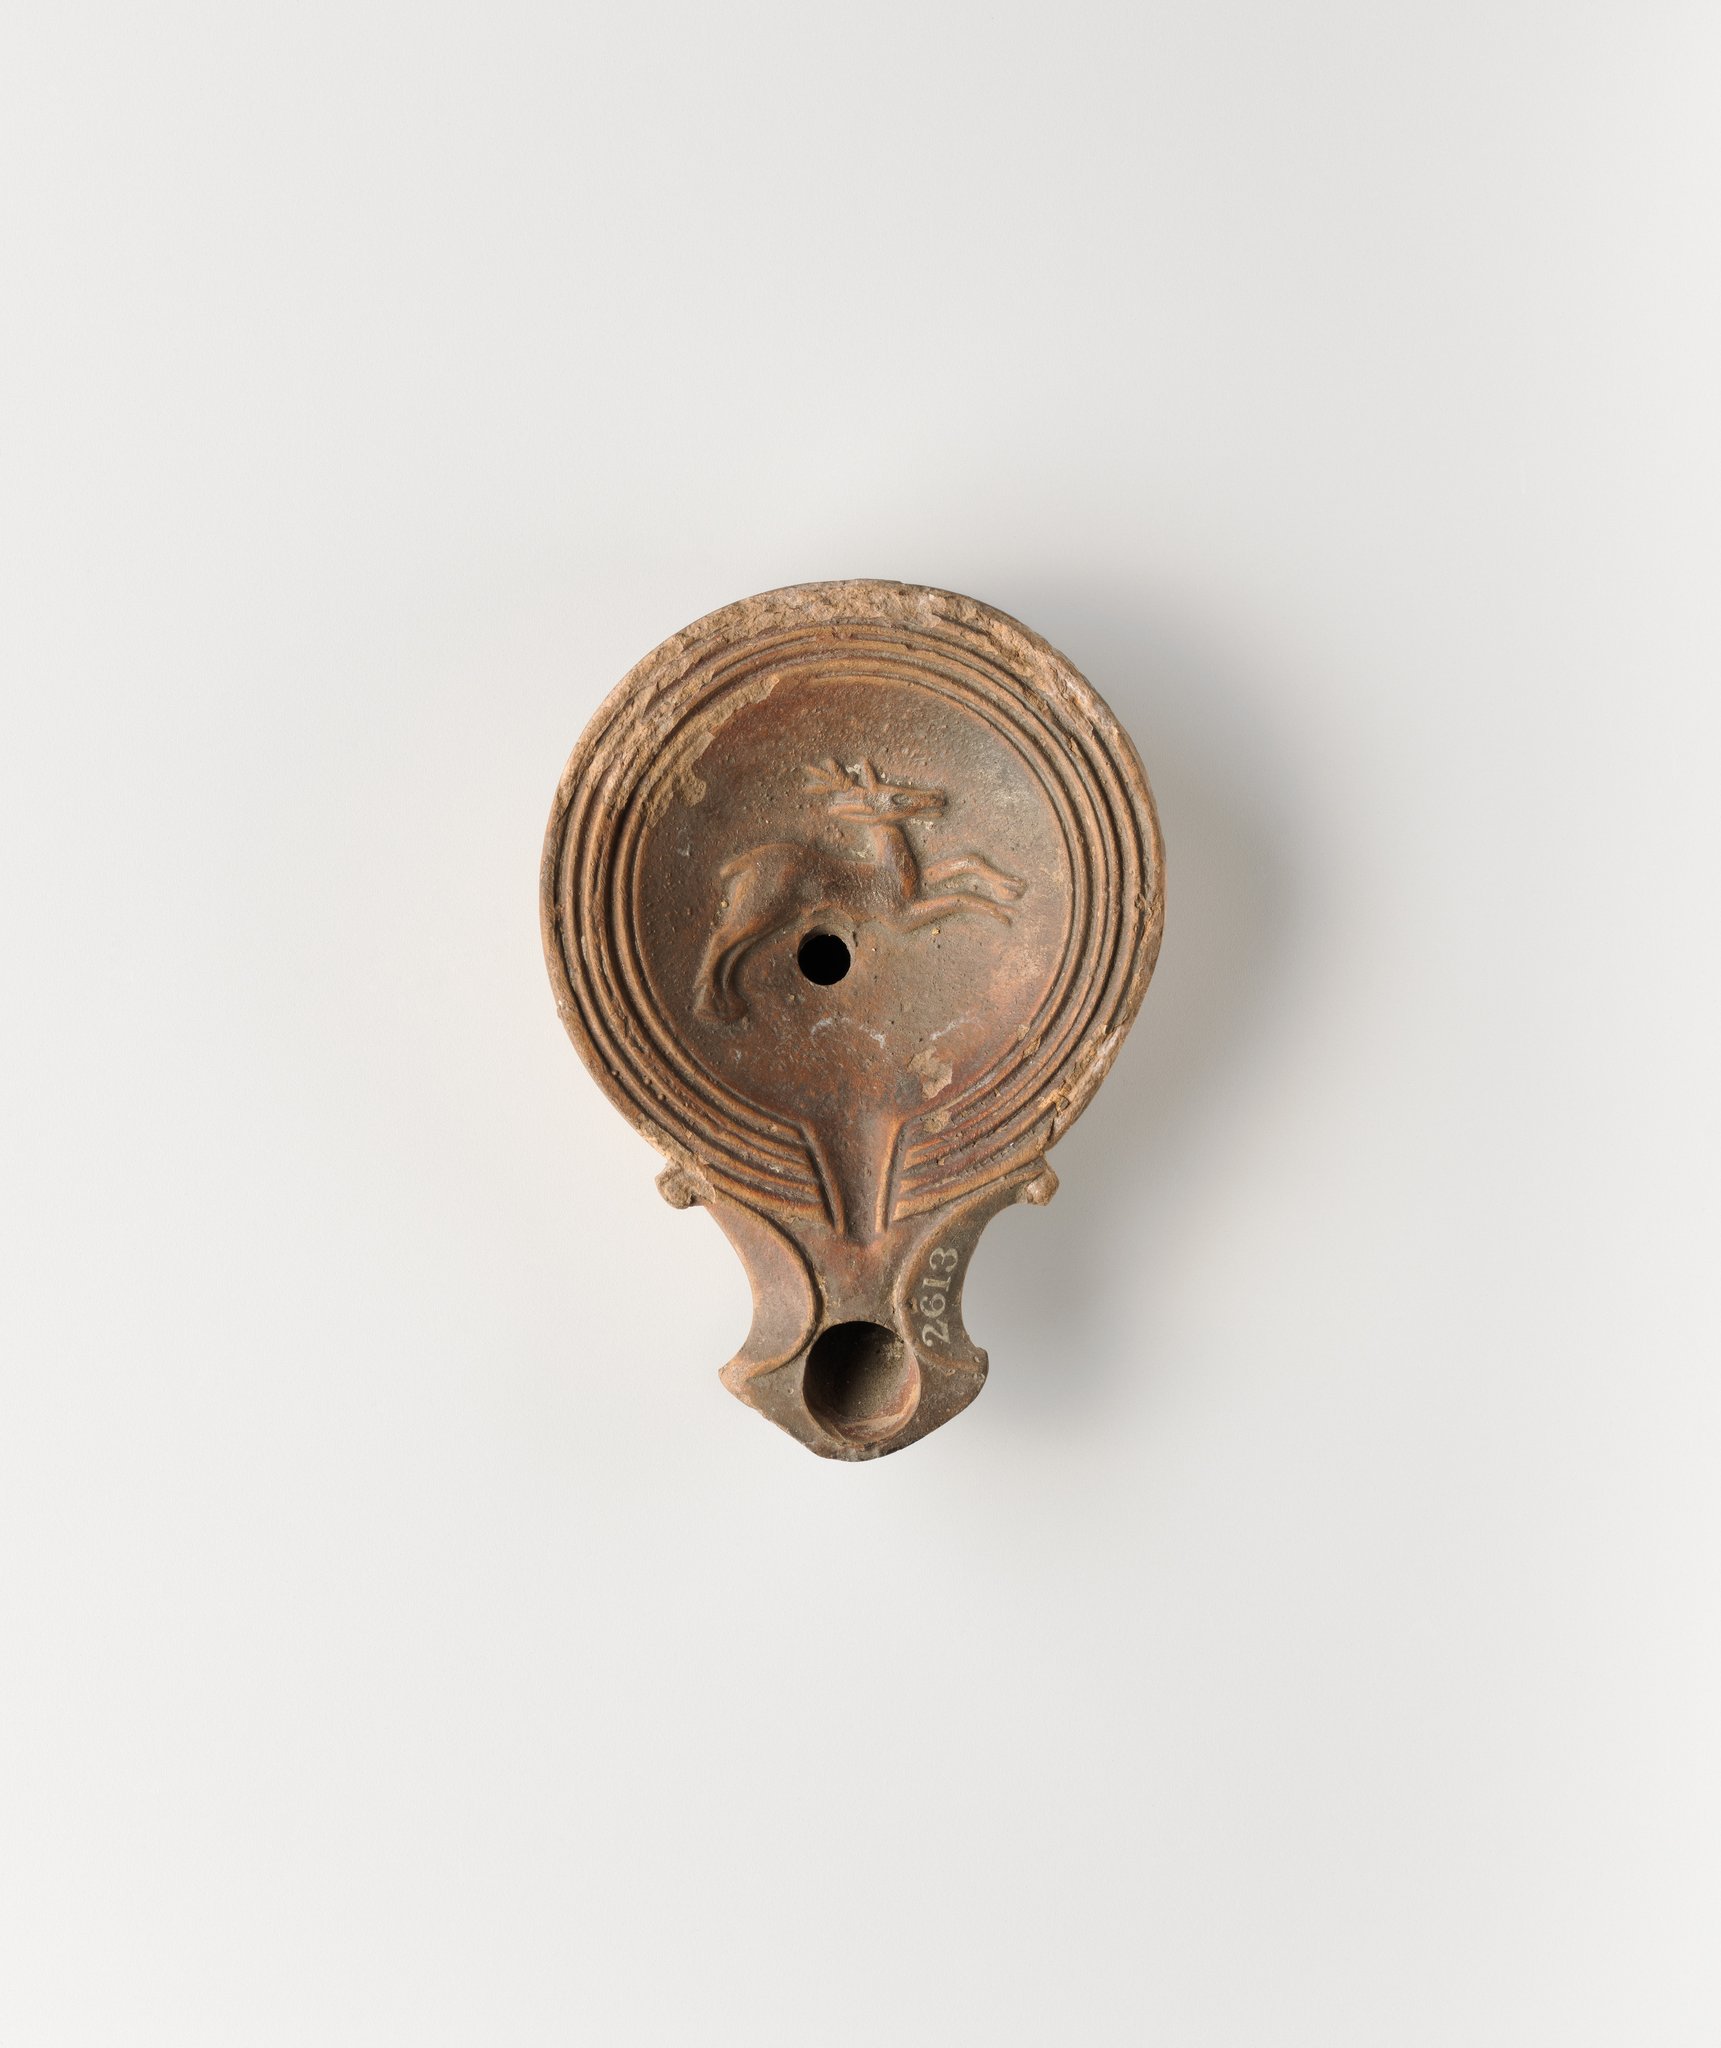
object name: lamp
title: Terracotta oil lamp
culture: roman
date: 100 BCE-100 CE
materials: terracotta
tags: deer